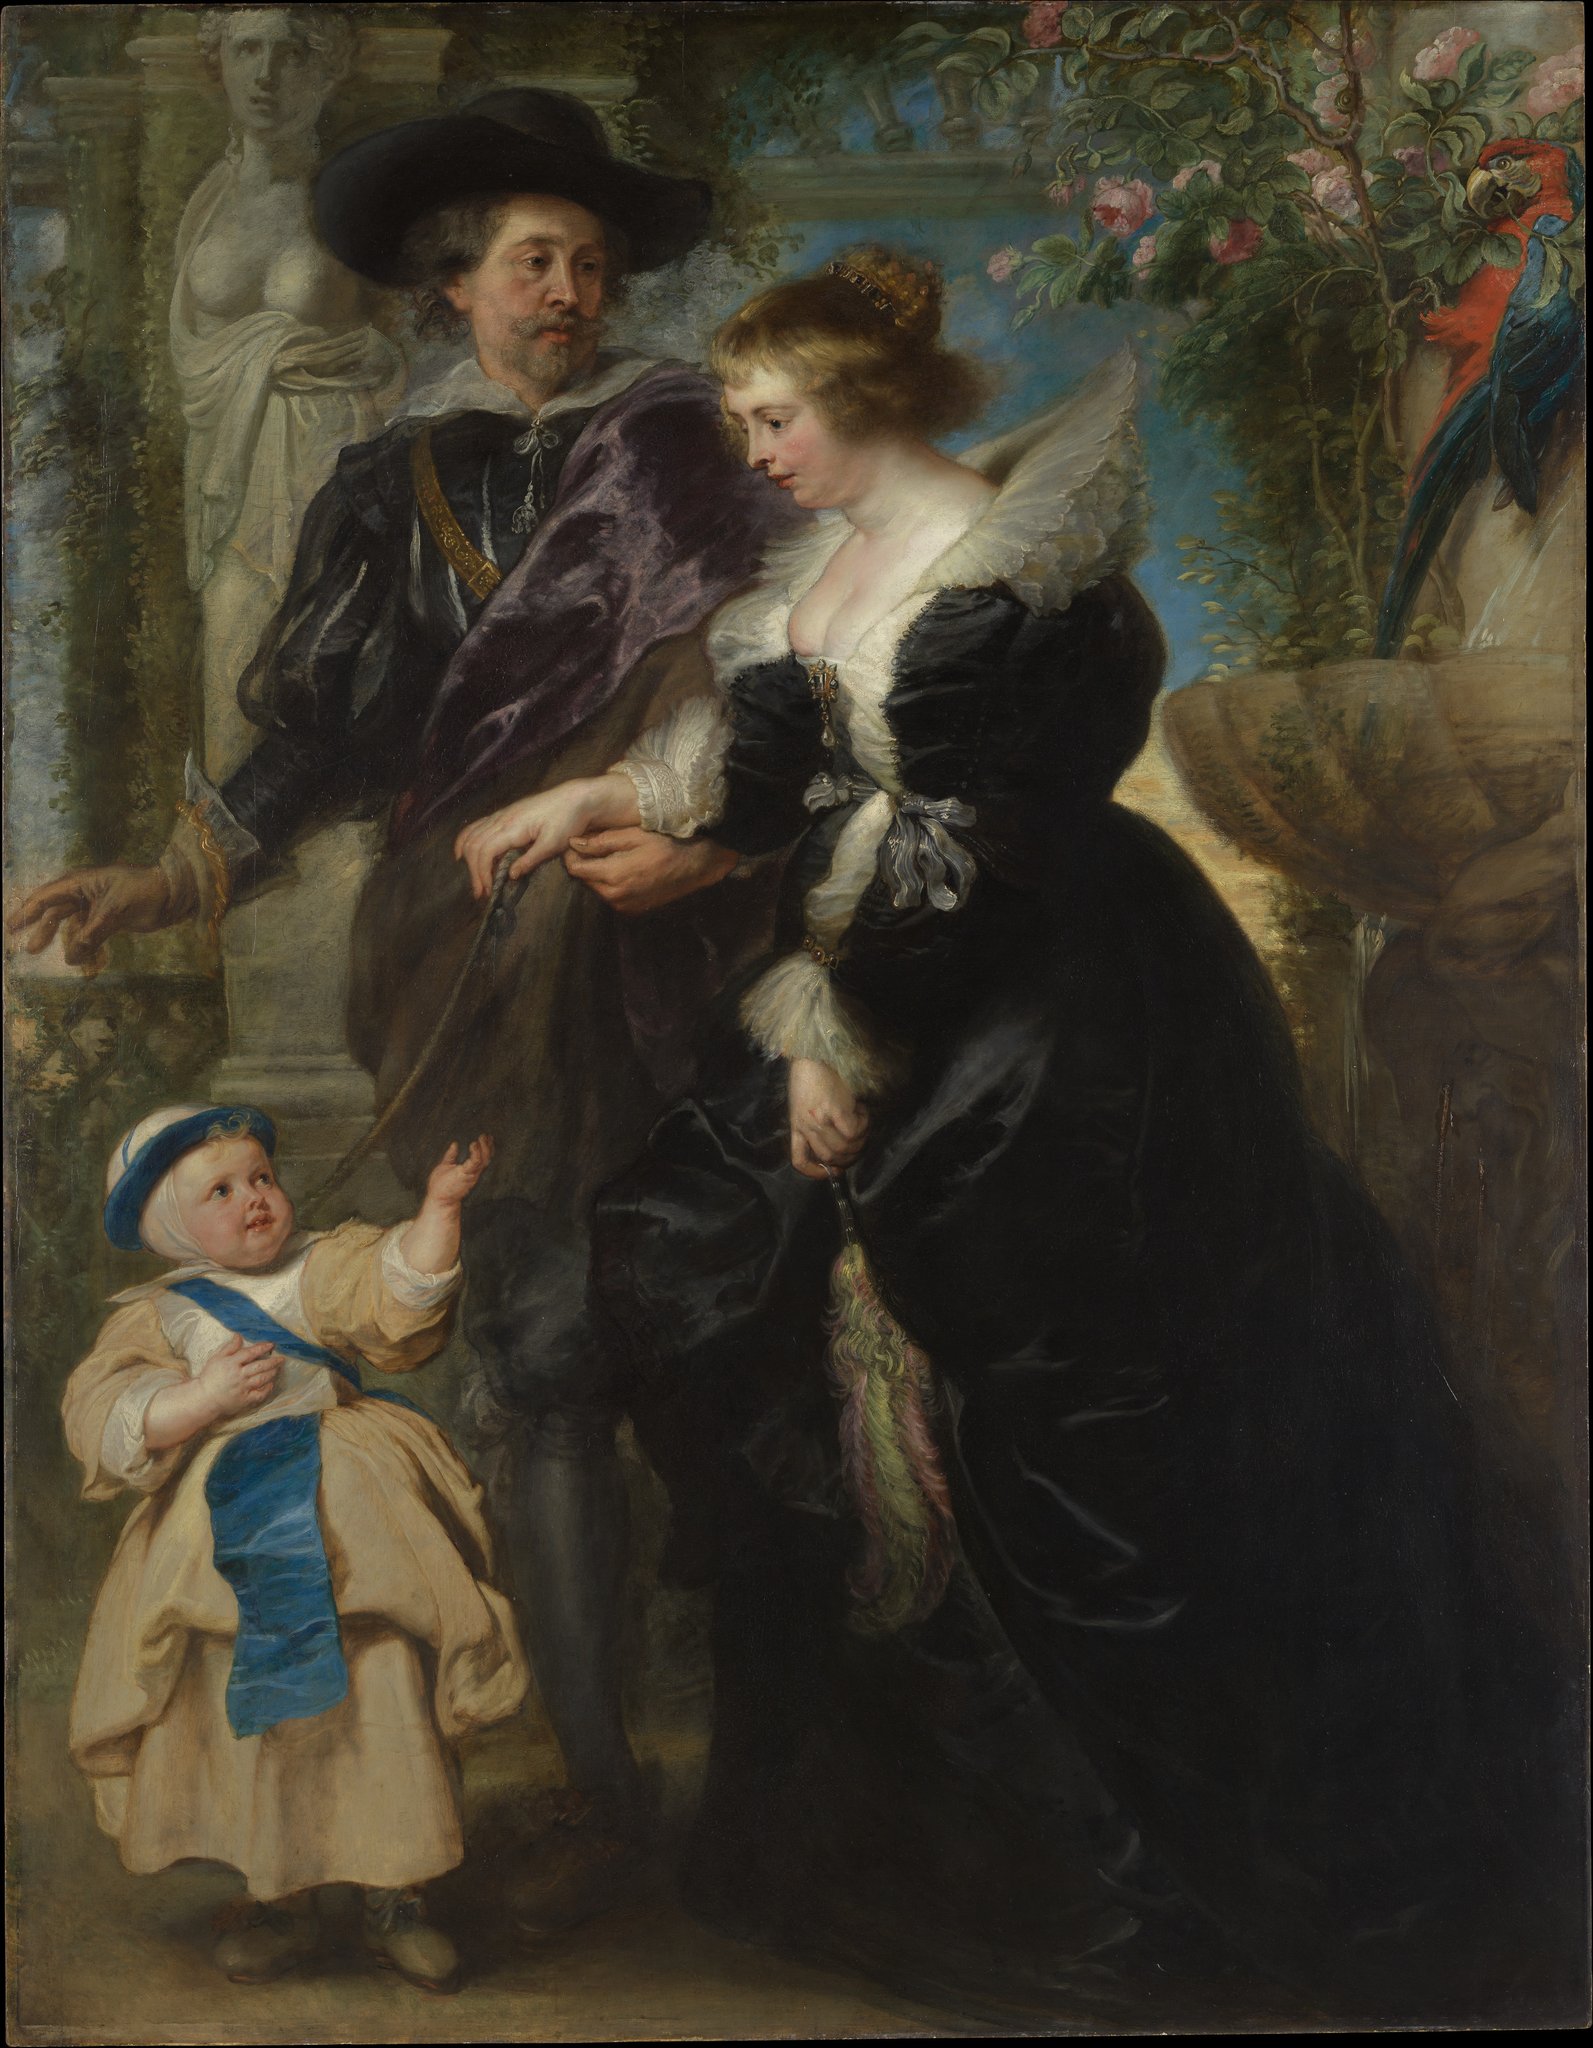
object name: painting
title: Rubens, Helena Fourment (1614–1673), and Their Son Frans (1633–1678)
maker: peter paul rubens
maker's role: artist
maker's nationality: flemish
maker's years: 1577-1640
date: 1635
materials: oil, wood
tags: boys,couples,men,portraits,self-portraits,women,parrots,family